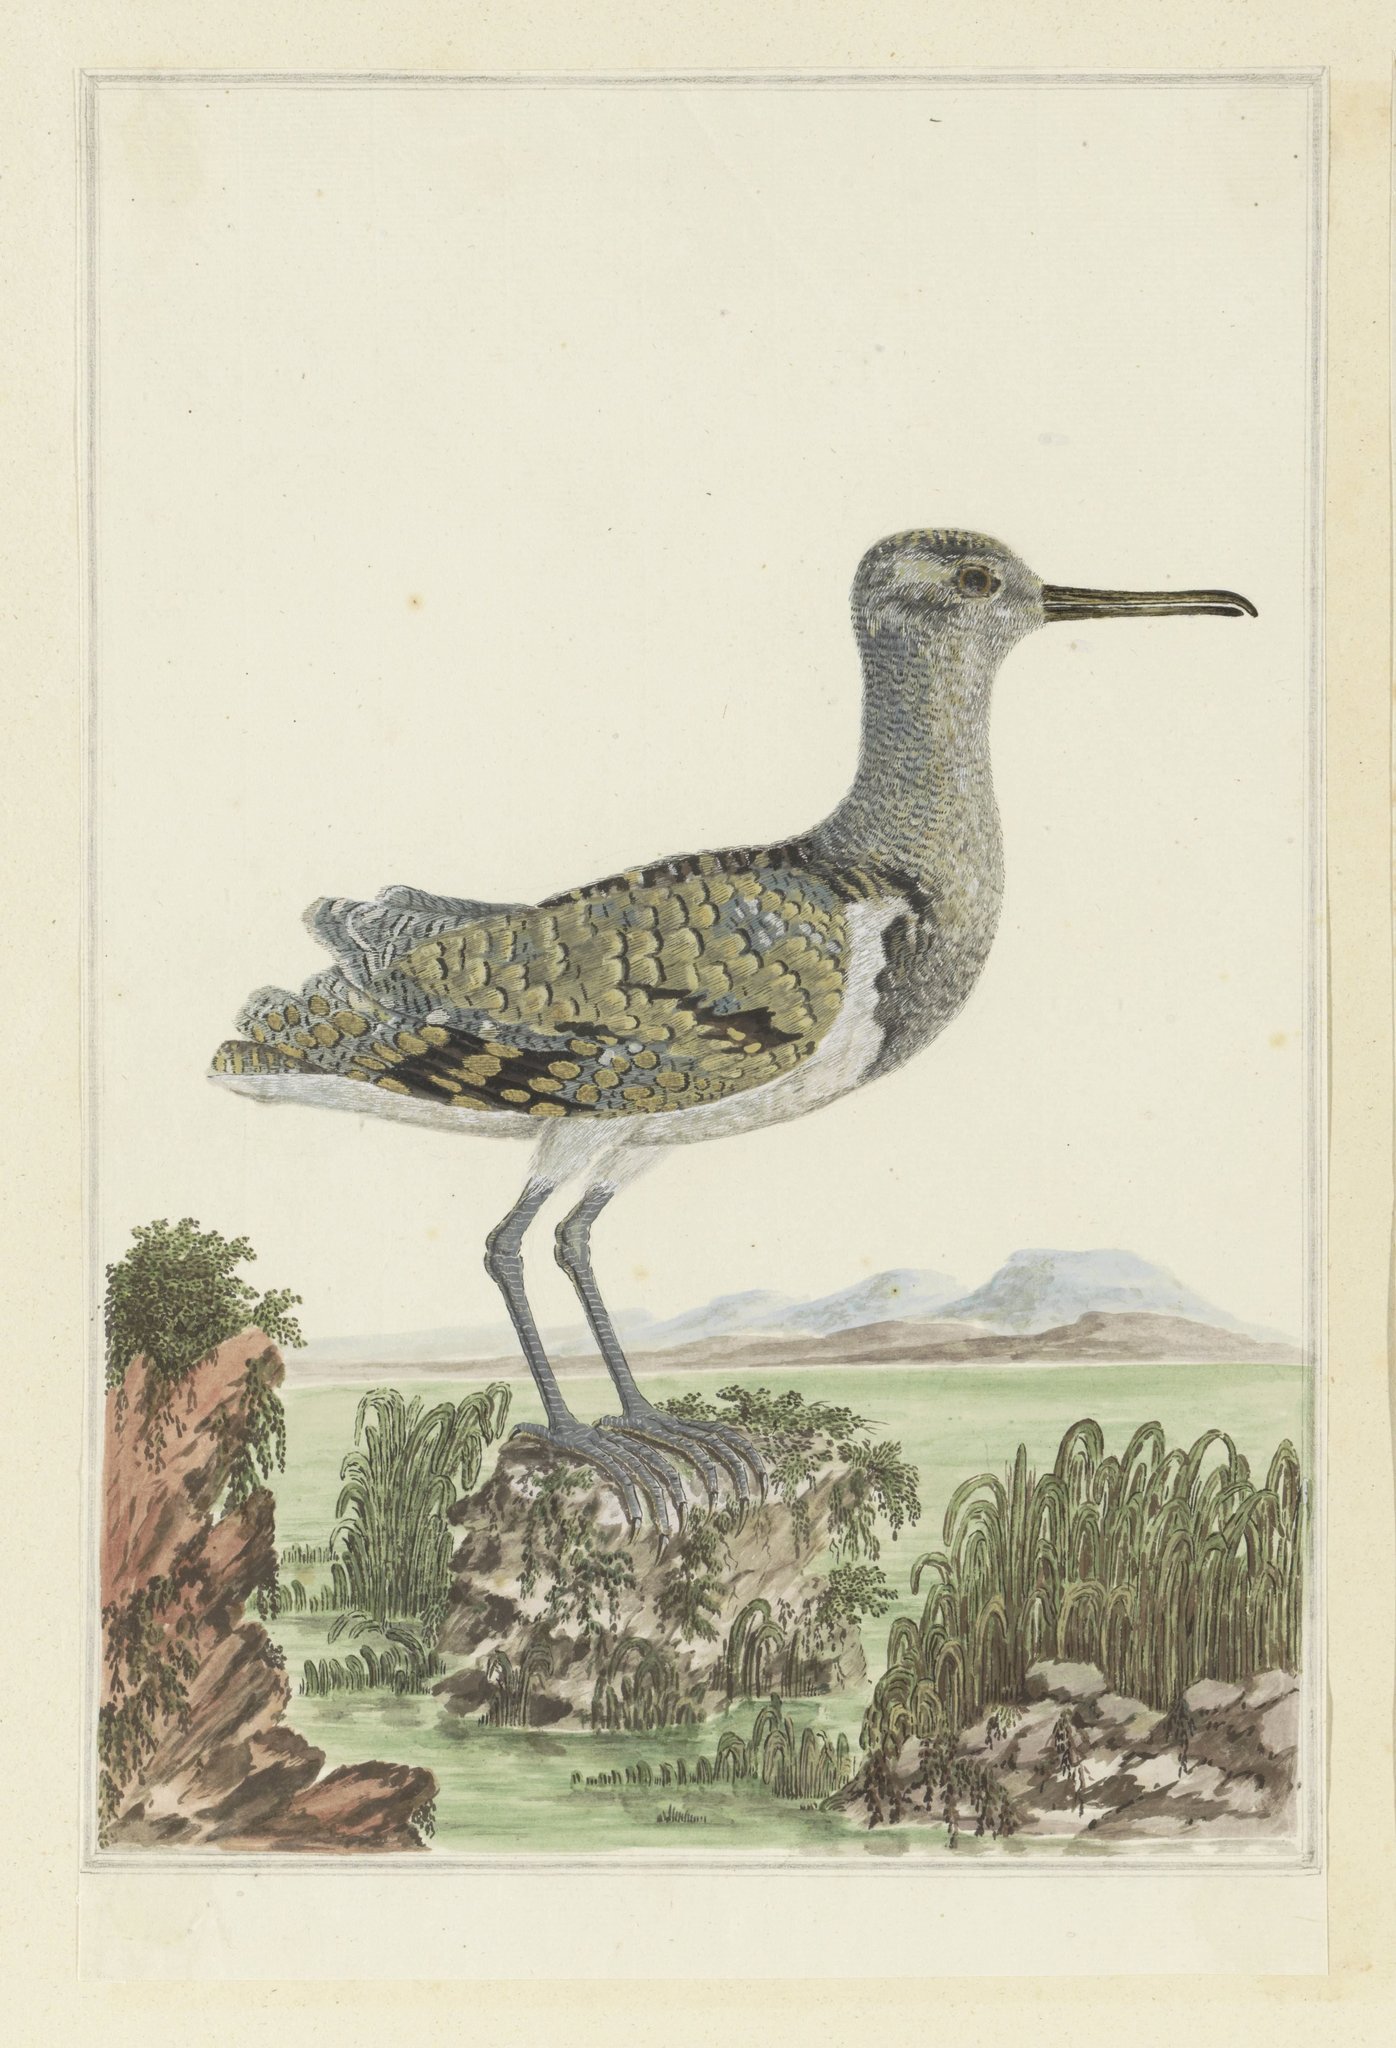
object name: drawing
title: Goudsnip (Rostratula benghalensis) in een gedetailleerd landschap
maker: robert jacob gordon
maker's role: draughtsman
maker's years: 1743-1795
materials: chalk, paint, ink, paper, pencil, watercolor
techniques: brush, pen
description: Vogelstudie: Goudsnip (Rostratula benghalensis).